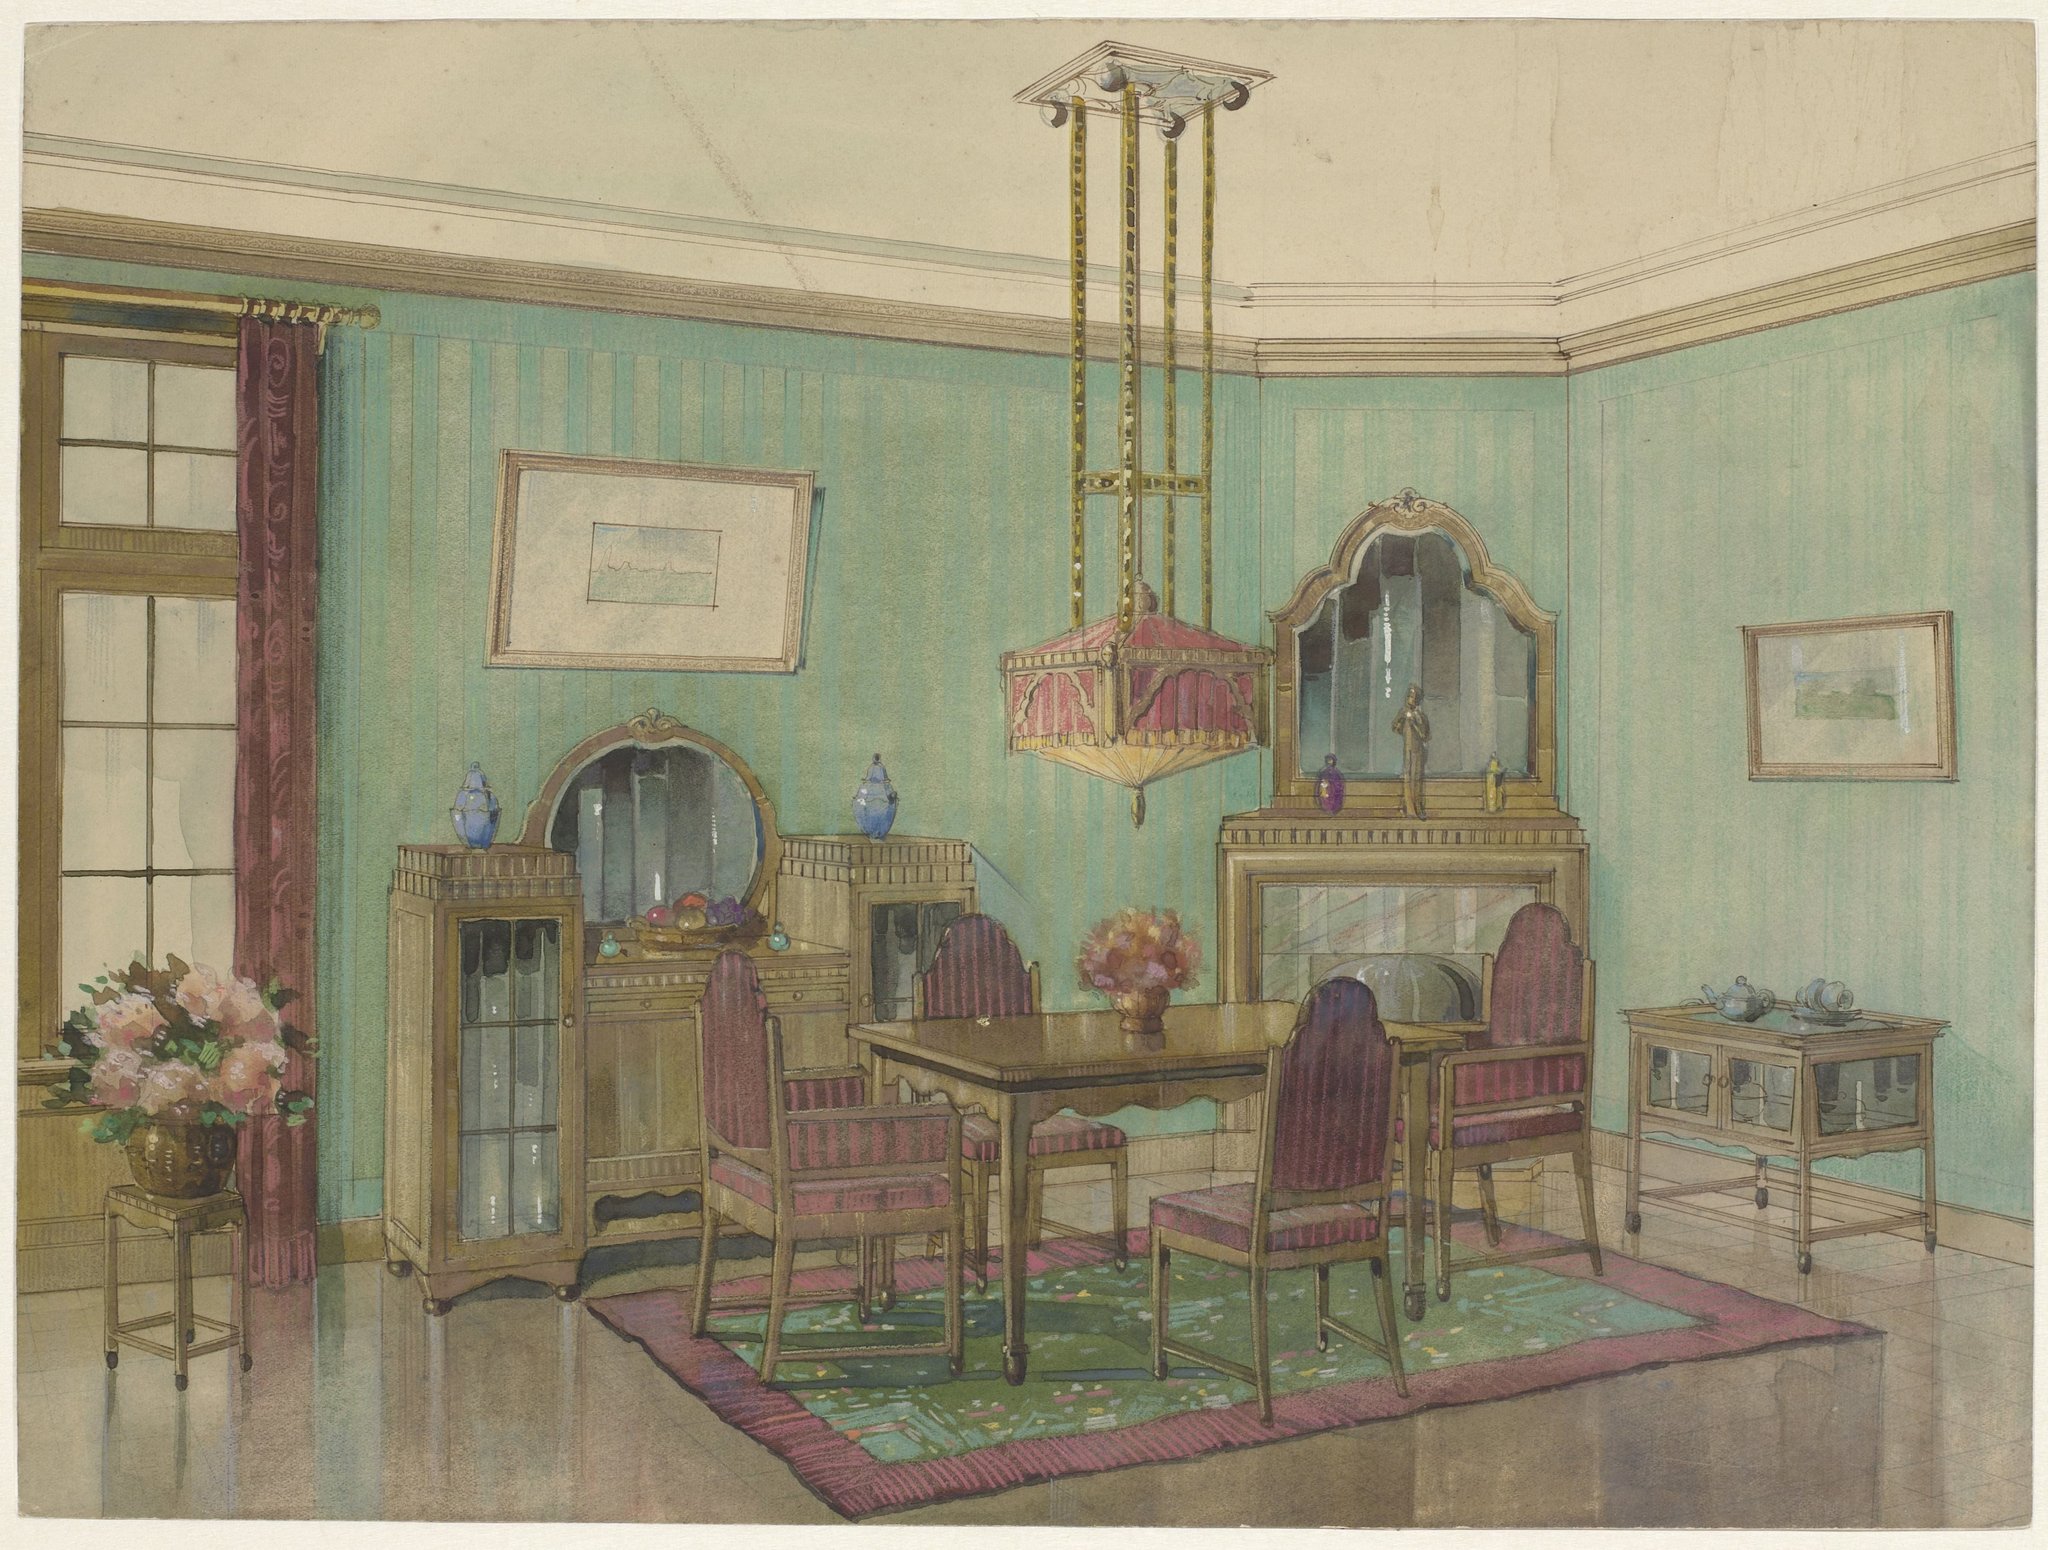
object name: drawing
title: Interior of dining room with corner chimney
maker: Anonymous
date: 1925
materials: paper, watercolor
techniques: brush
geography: netherlands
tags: dining-room